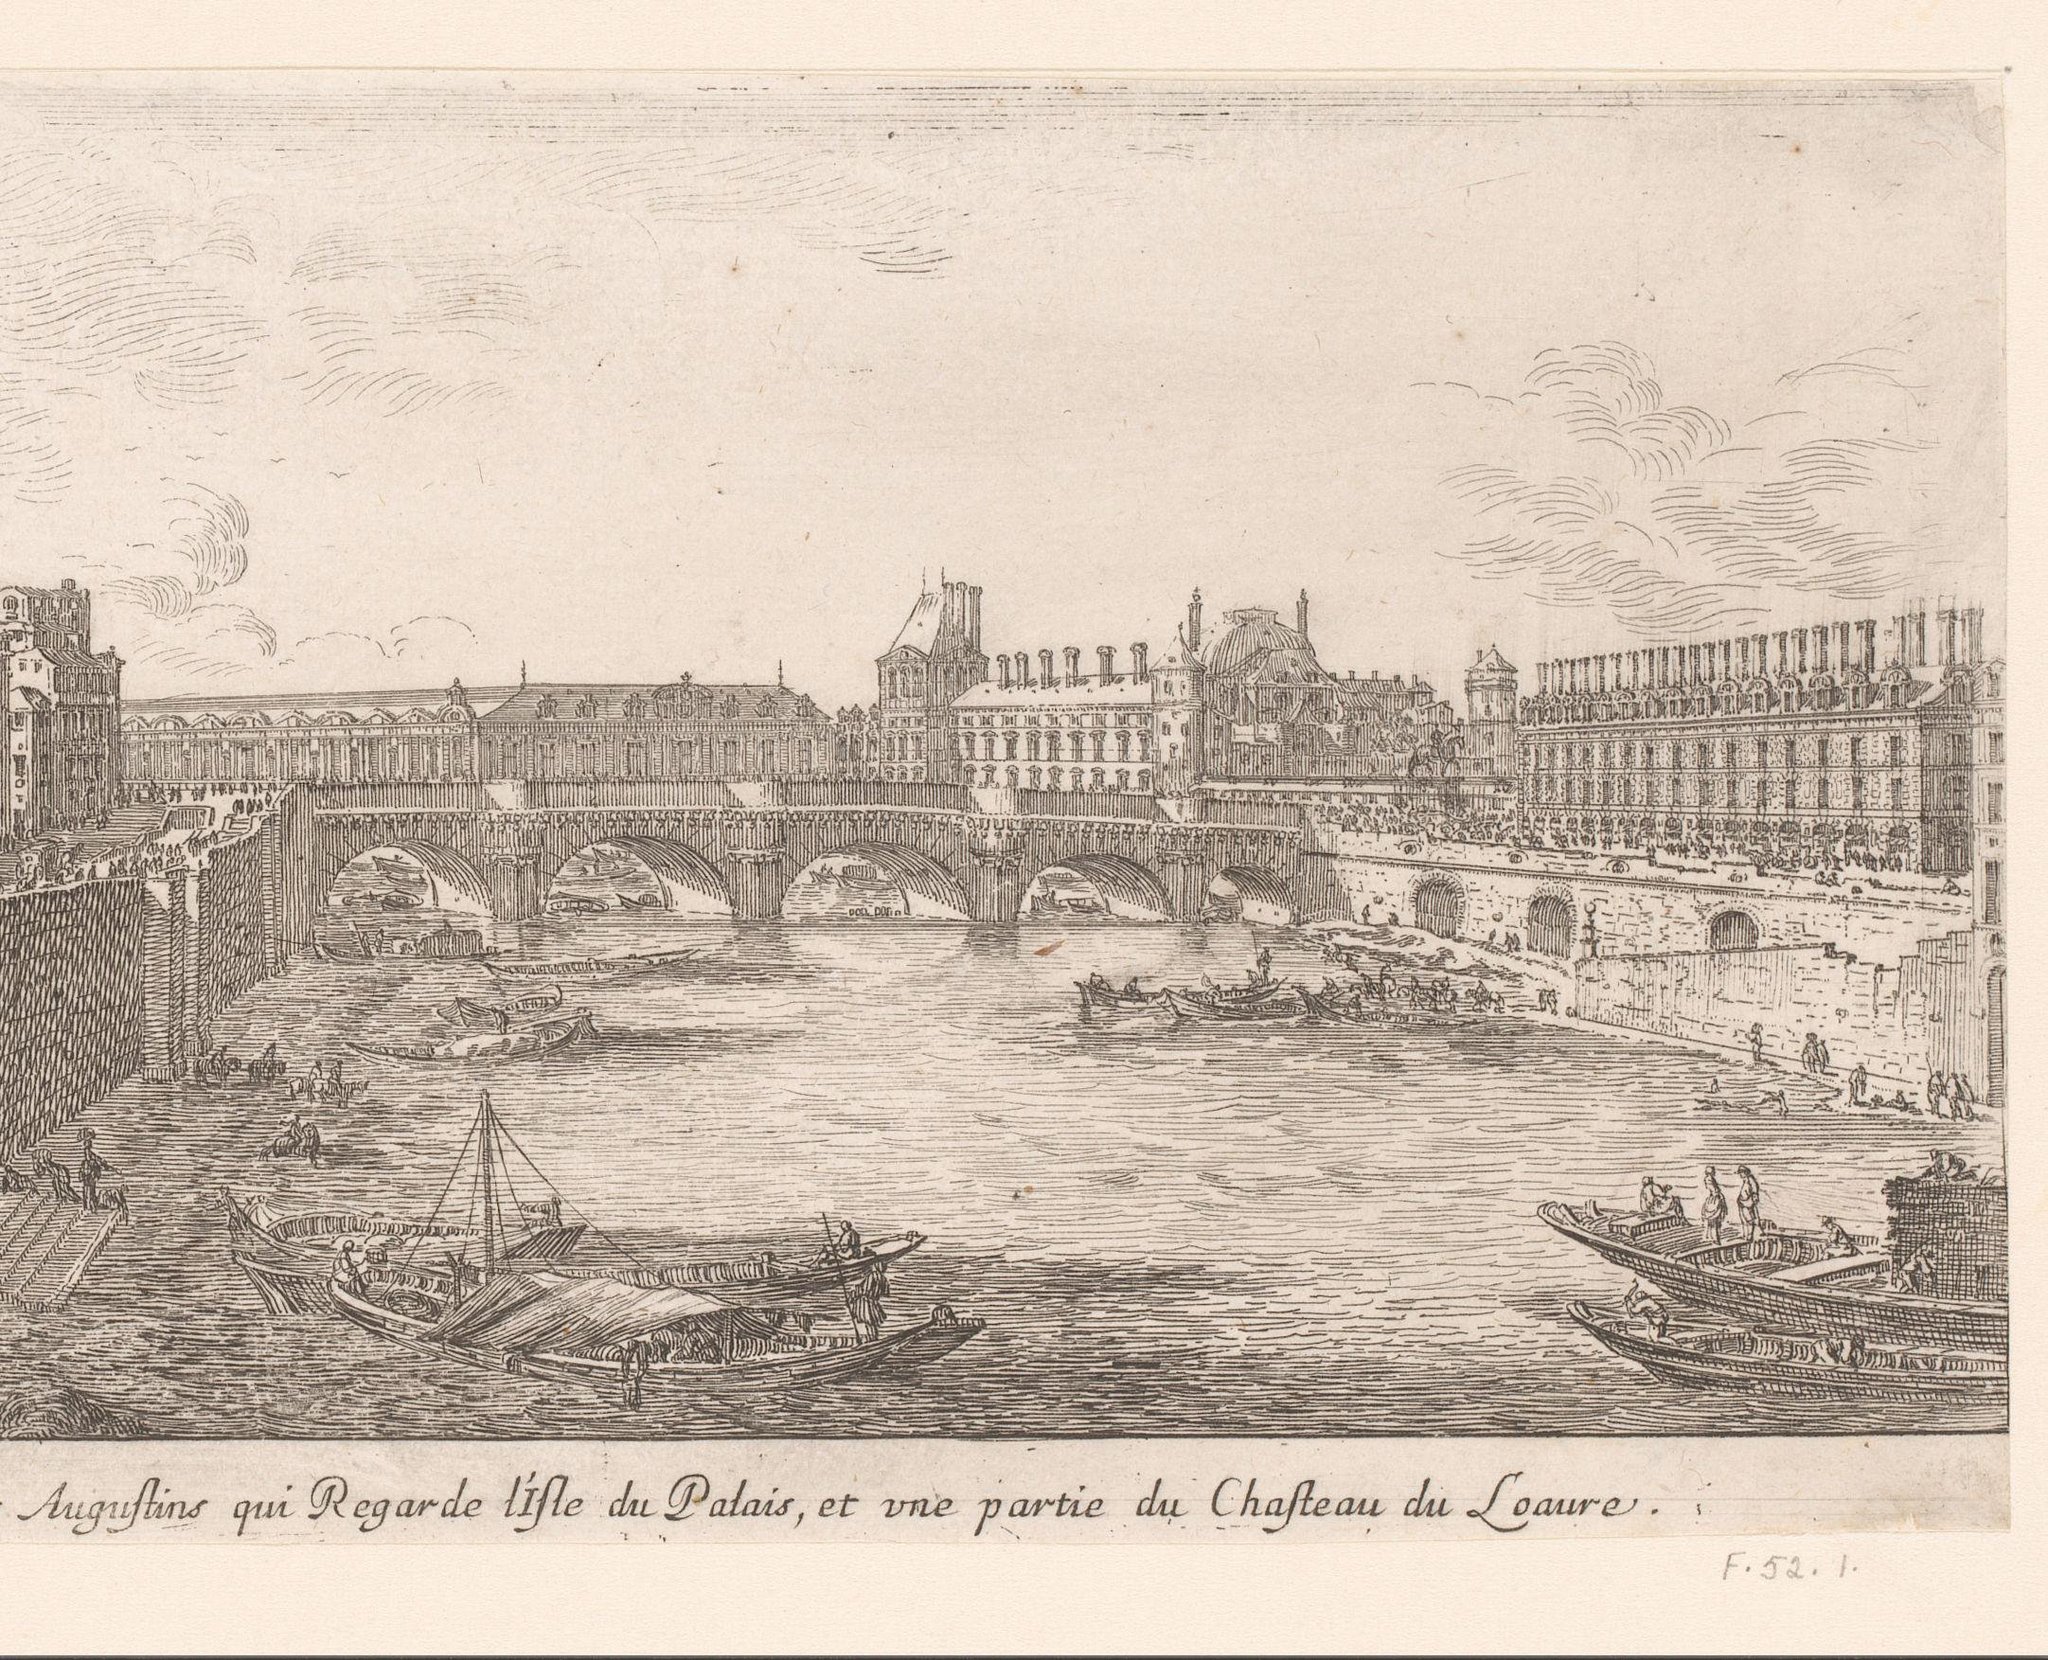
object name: print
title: Veue du grand Convent des Augustines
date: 1650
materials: paper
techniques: etching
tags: landscape with bridge, viaduct or aqueduct, abbey, monastery, convent ~ roman catholic church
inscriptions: collector's mark: Lugt 240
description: Prent maakt deel uit van een ongenummerde serie van zestien prenten.